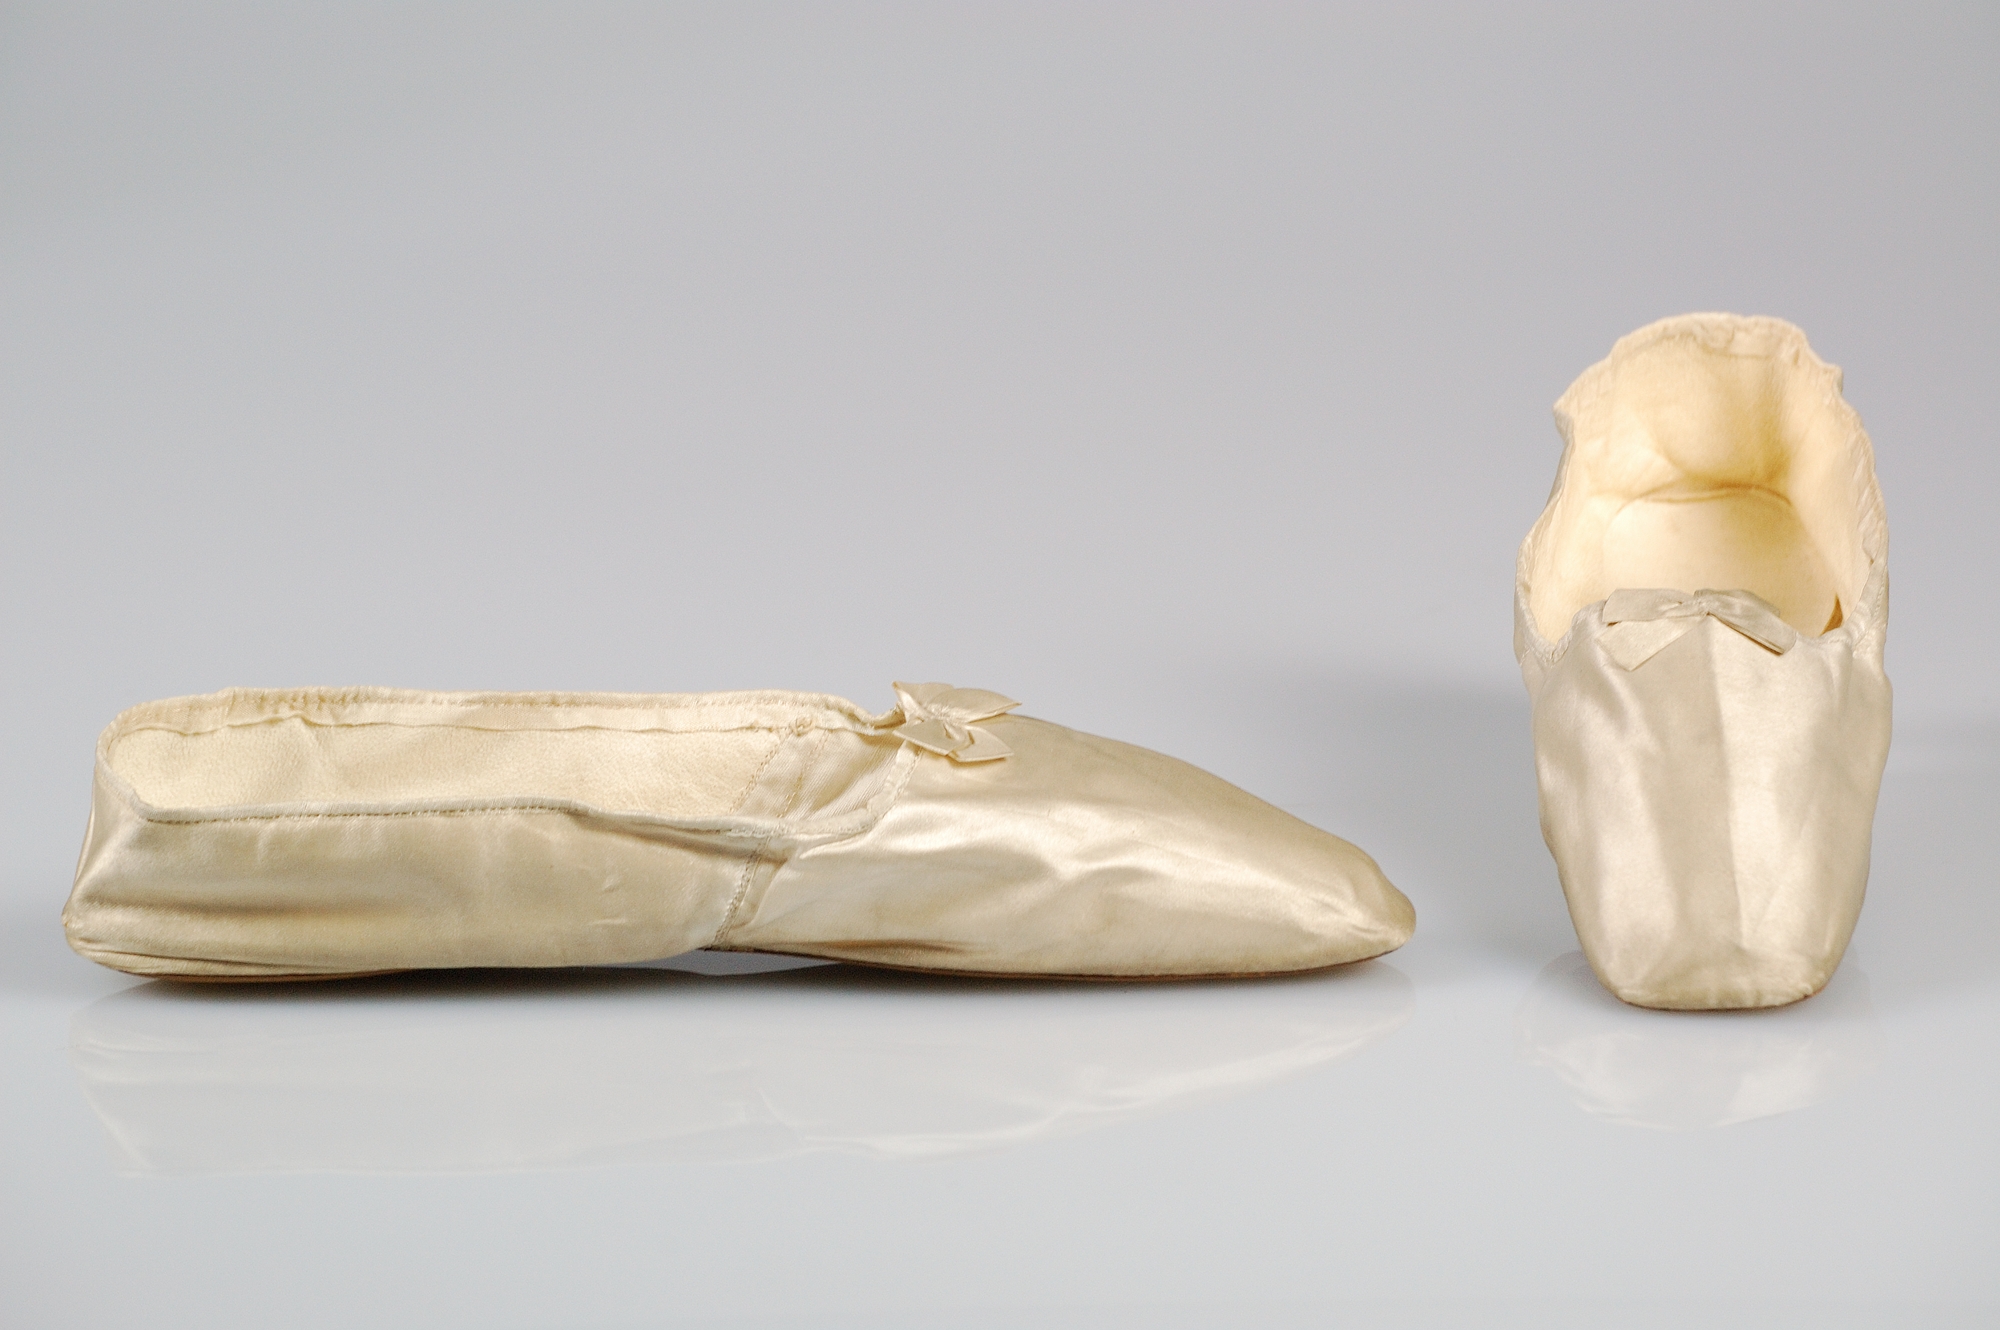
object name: evening slipper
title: Evening slippers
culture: french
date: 1845-1865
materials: silk